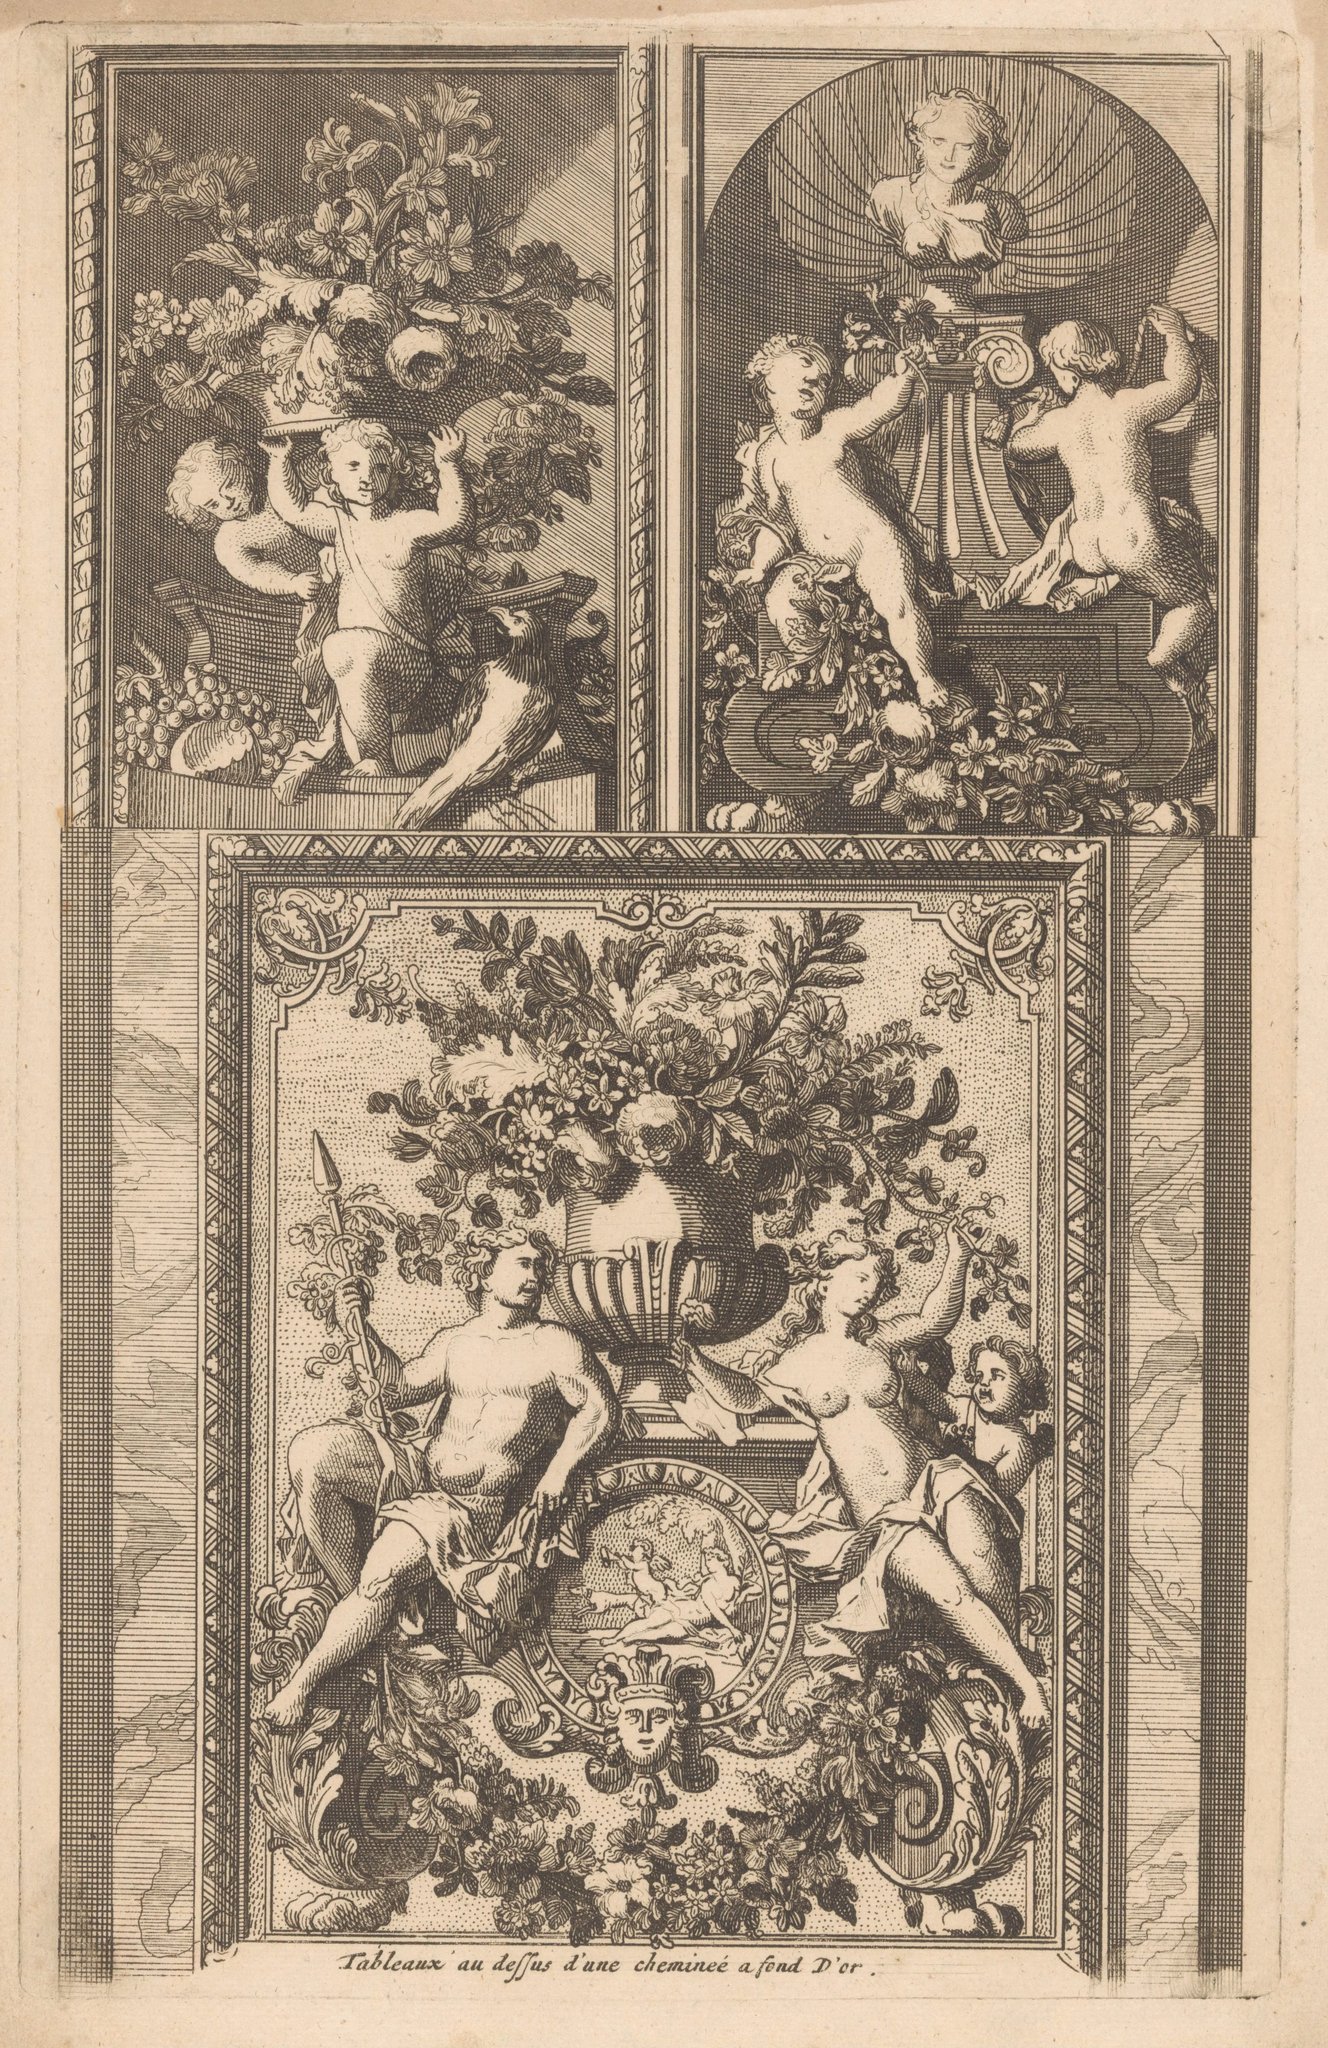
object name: print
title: Nouveaux Livre de Taleaux de Portes, et cheminée Utiles aux Peintres Enfloeurs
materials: paper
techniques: etching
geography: amsterdam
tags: panelling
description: Drie panelen. Links boven dragen putti een bloemenmand. Rechts boven een vrouwenbuste op voetstuk geflankeerd door twee putti. Midden onder flankeren een man, vrouw en putti een bloemenvaas op een voetstuk met Diana in medaillon.